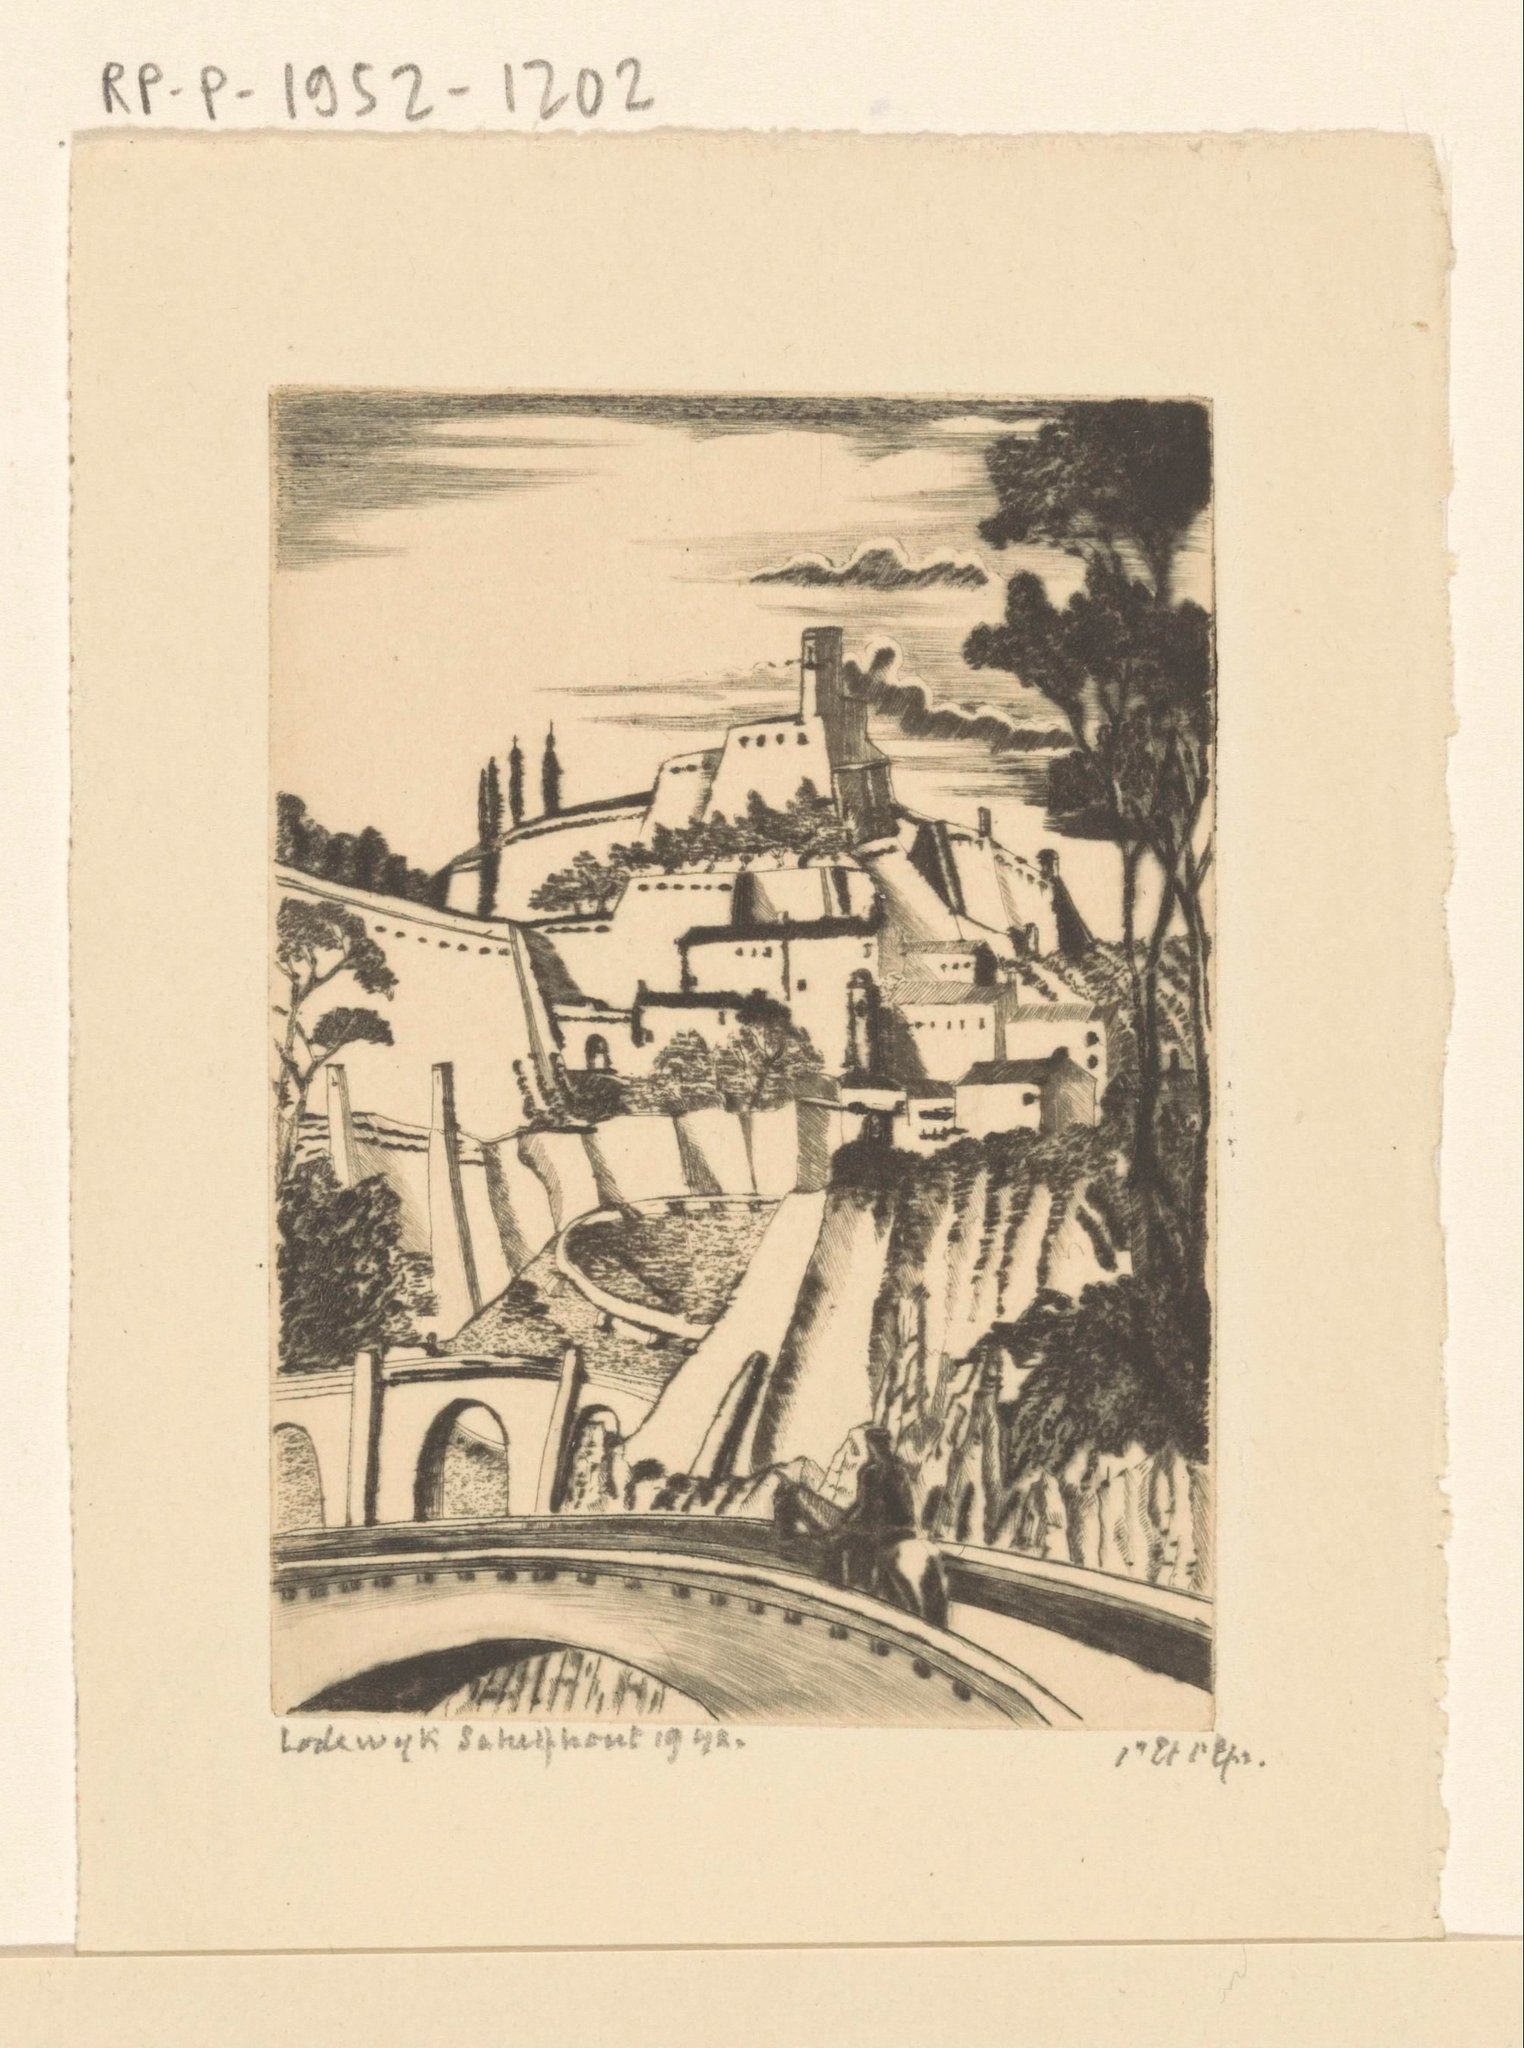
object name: print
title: Le Château III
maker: lodewijk schelfhout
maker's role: draughtsman, print maker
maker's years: 1881-1943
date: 1942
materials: paper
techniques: drypoint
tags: riding a horse, ass, or mule; rider, horseman, low hill country, landscape with tower or castle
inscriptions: collector's mark: Lugt 5i, collector's mark: Lugt 2228